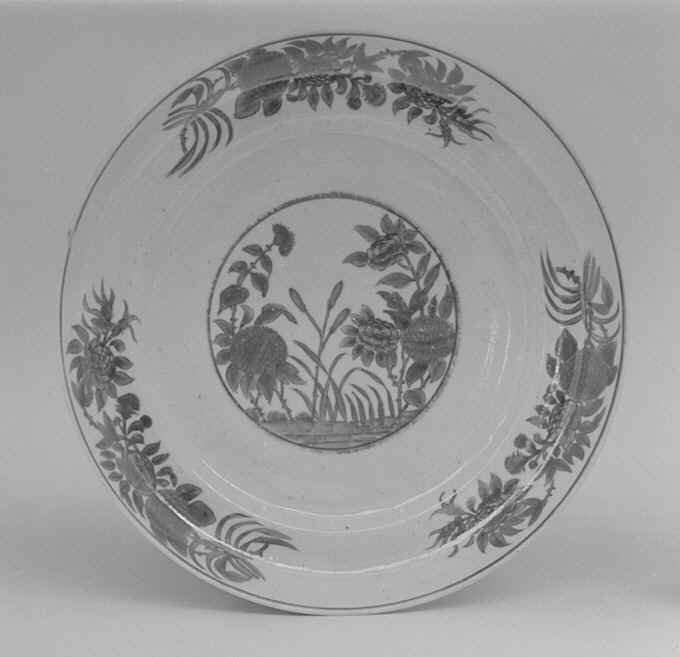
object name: plate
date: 1776-1800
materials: hard paste porcelain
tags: flowers